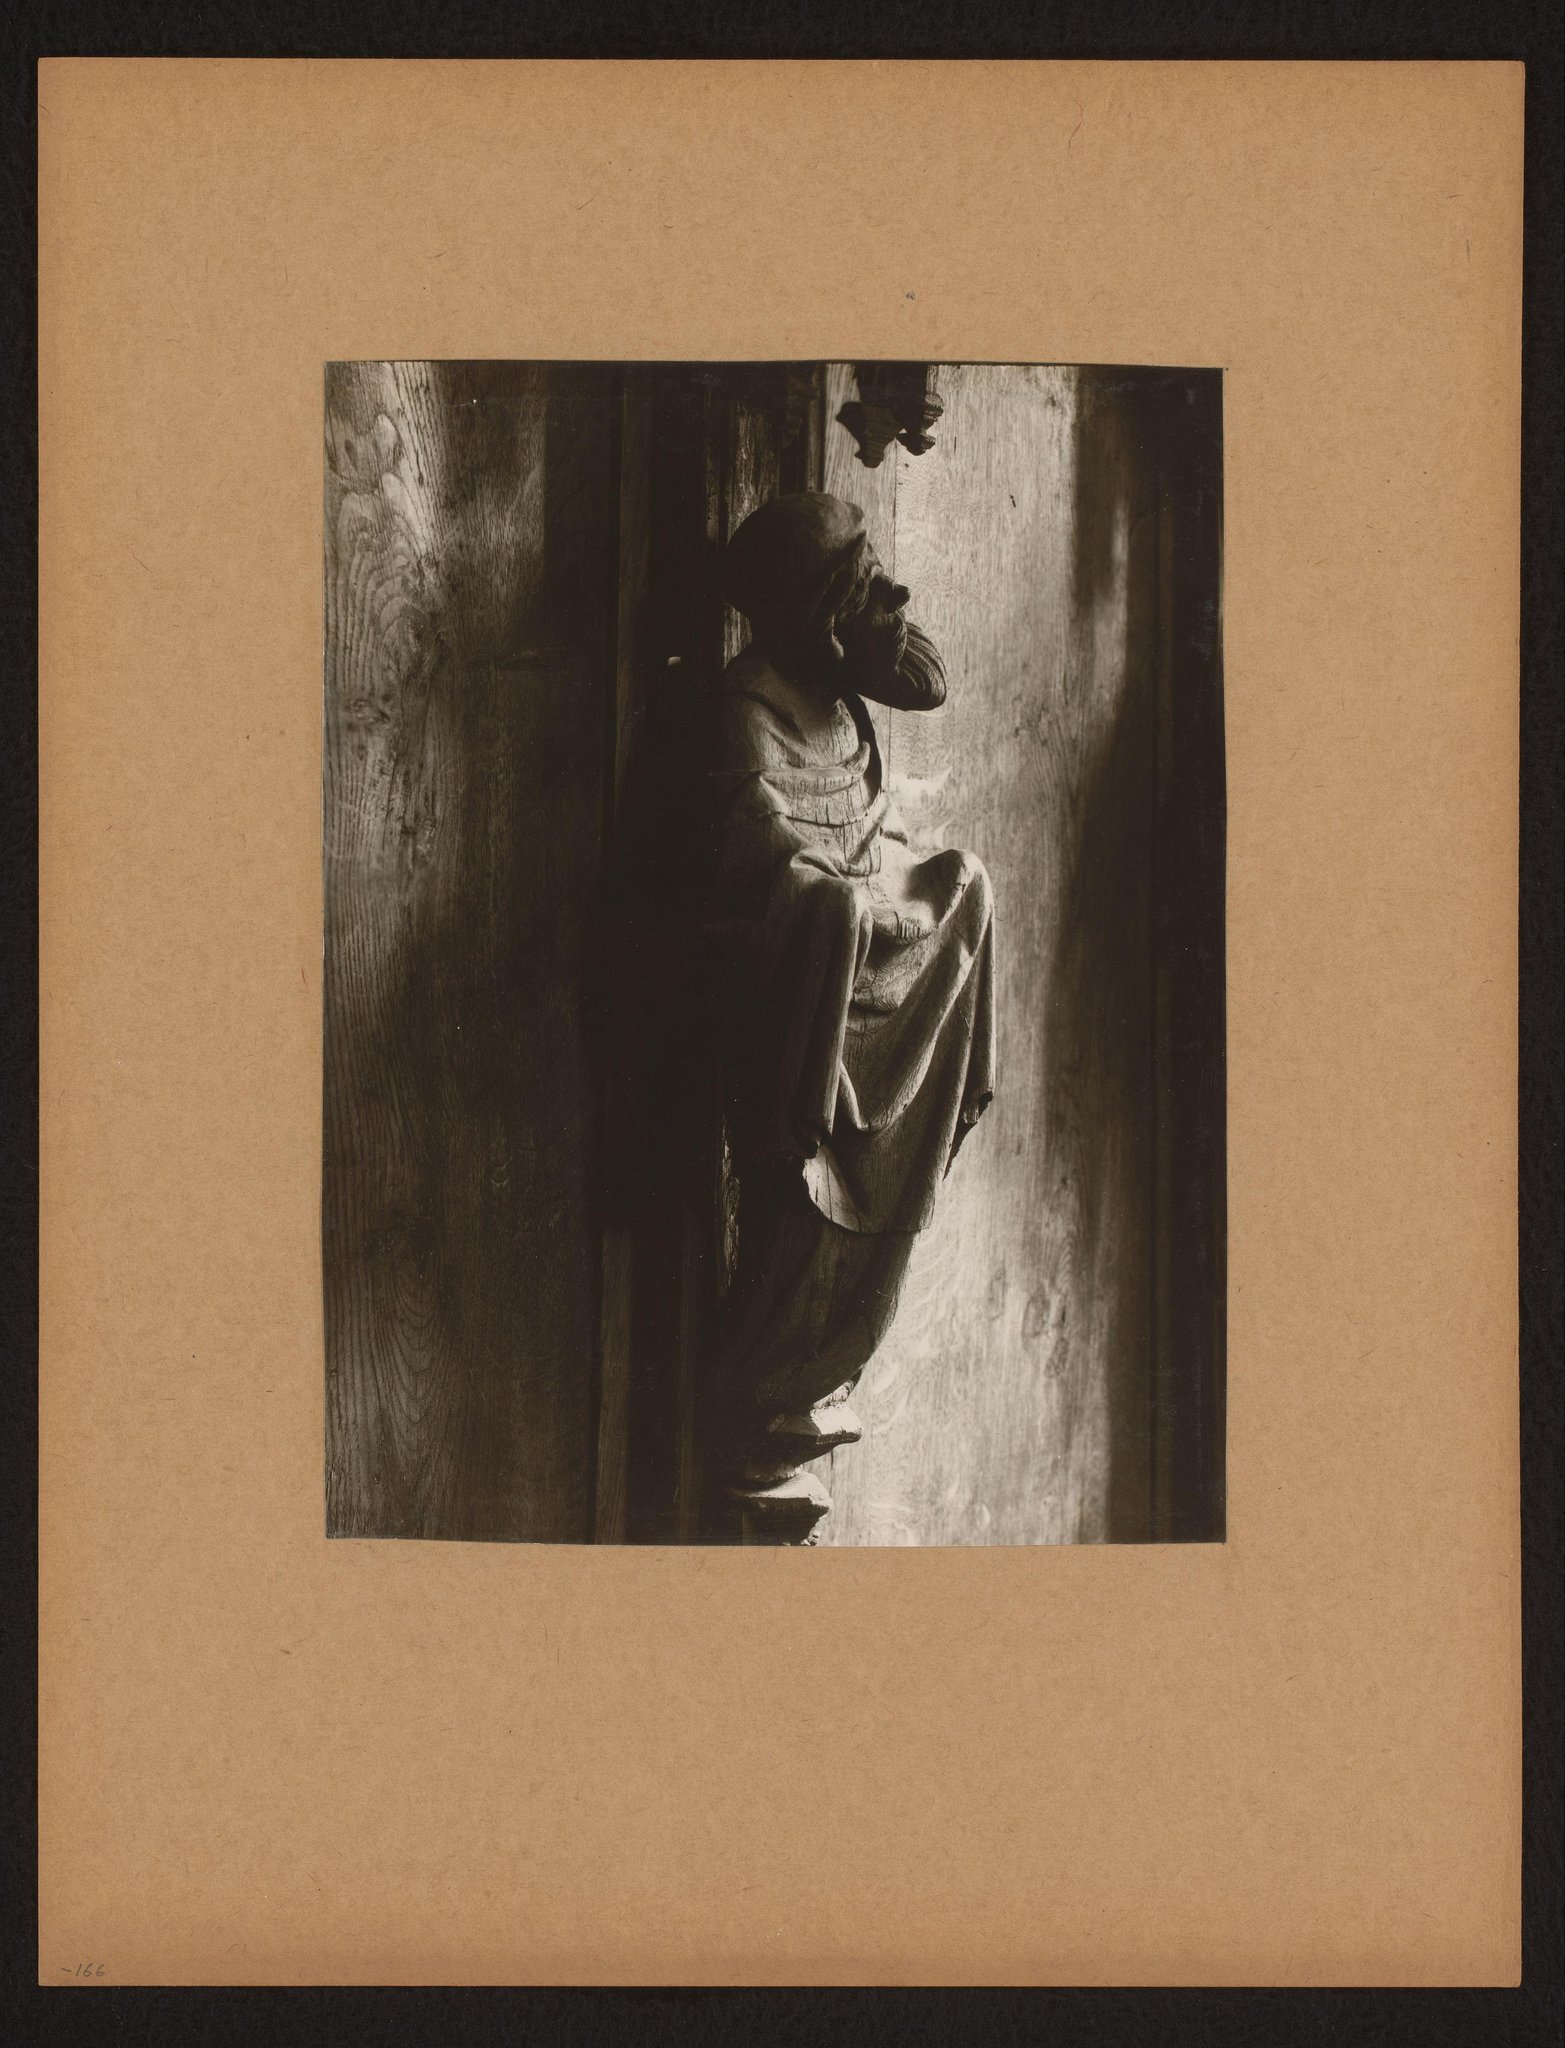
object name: album leaf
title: Detail van het koorgestoelte in de dom van Bamberg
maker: Anonymous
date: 1900-1920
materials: paper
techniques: gelatin silver print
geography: bamberg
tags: interior of church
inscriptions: number: ‘169’